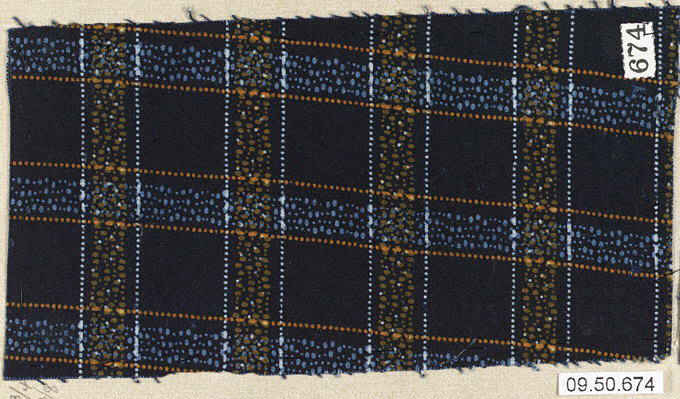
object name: piece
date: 1801-1900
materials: cotton